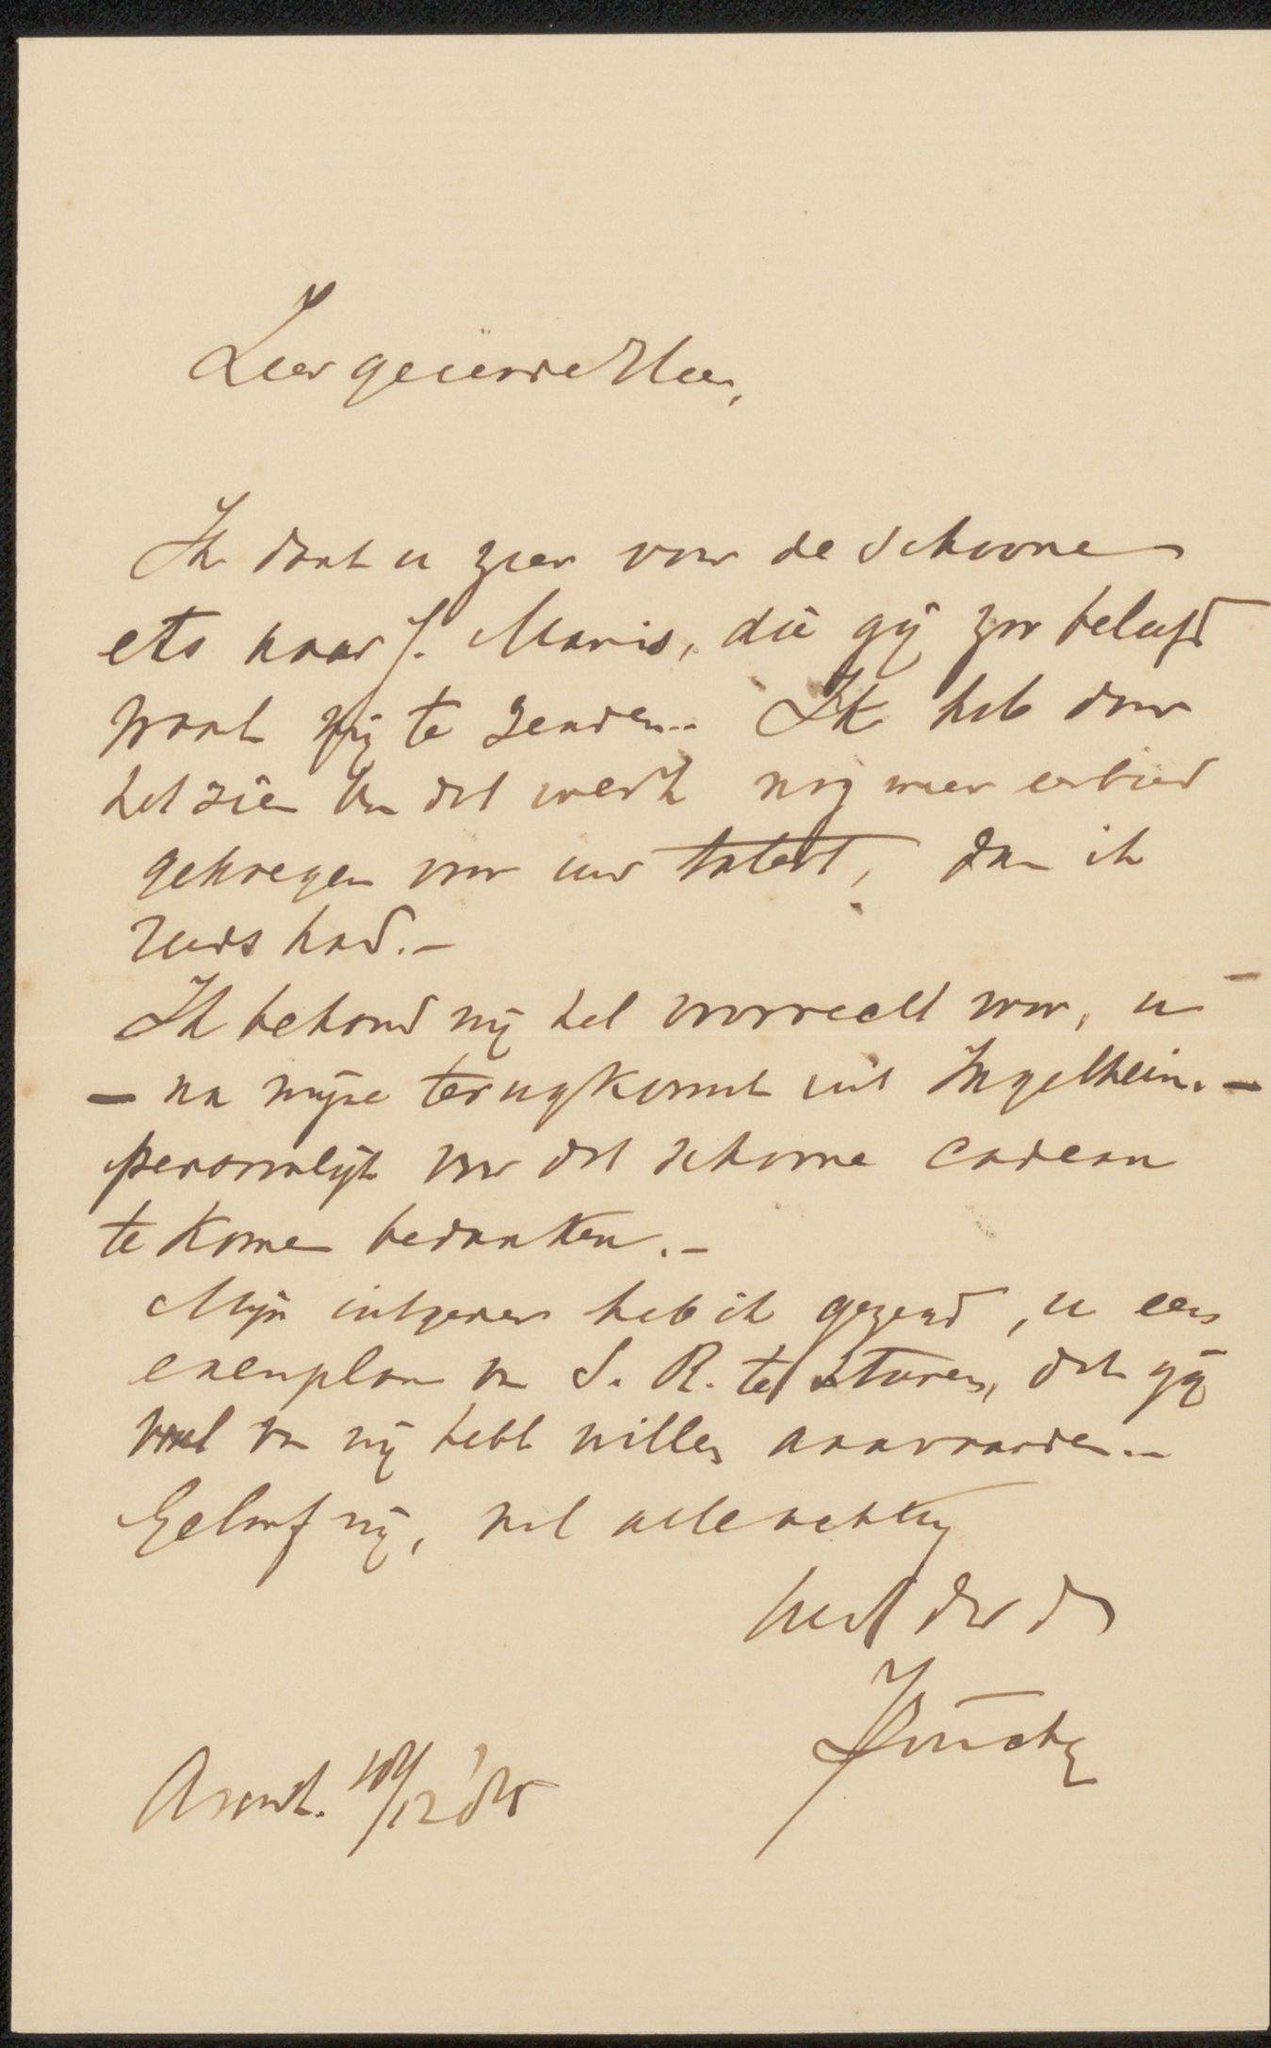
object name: letter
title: Brief aan Philip Zilcken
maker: jan zürcher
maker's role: painter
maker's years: 1851-1905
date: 1885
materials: ink, paper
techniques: pen, writing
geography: amsterdam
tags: painter, print maker, draughtsman, jacob maris, philip zilcken, the graphic arts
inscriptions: watermark, collector's mark: ‘RPK’